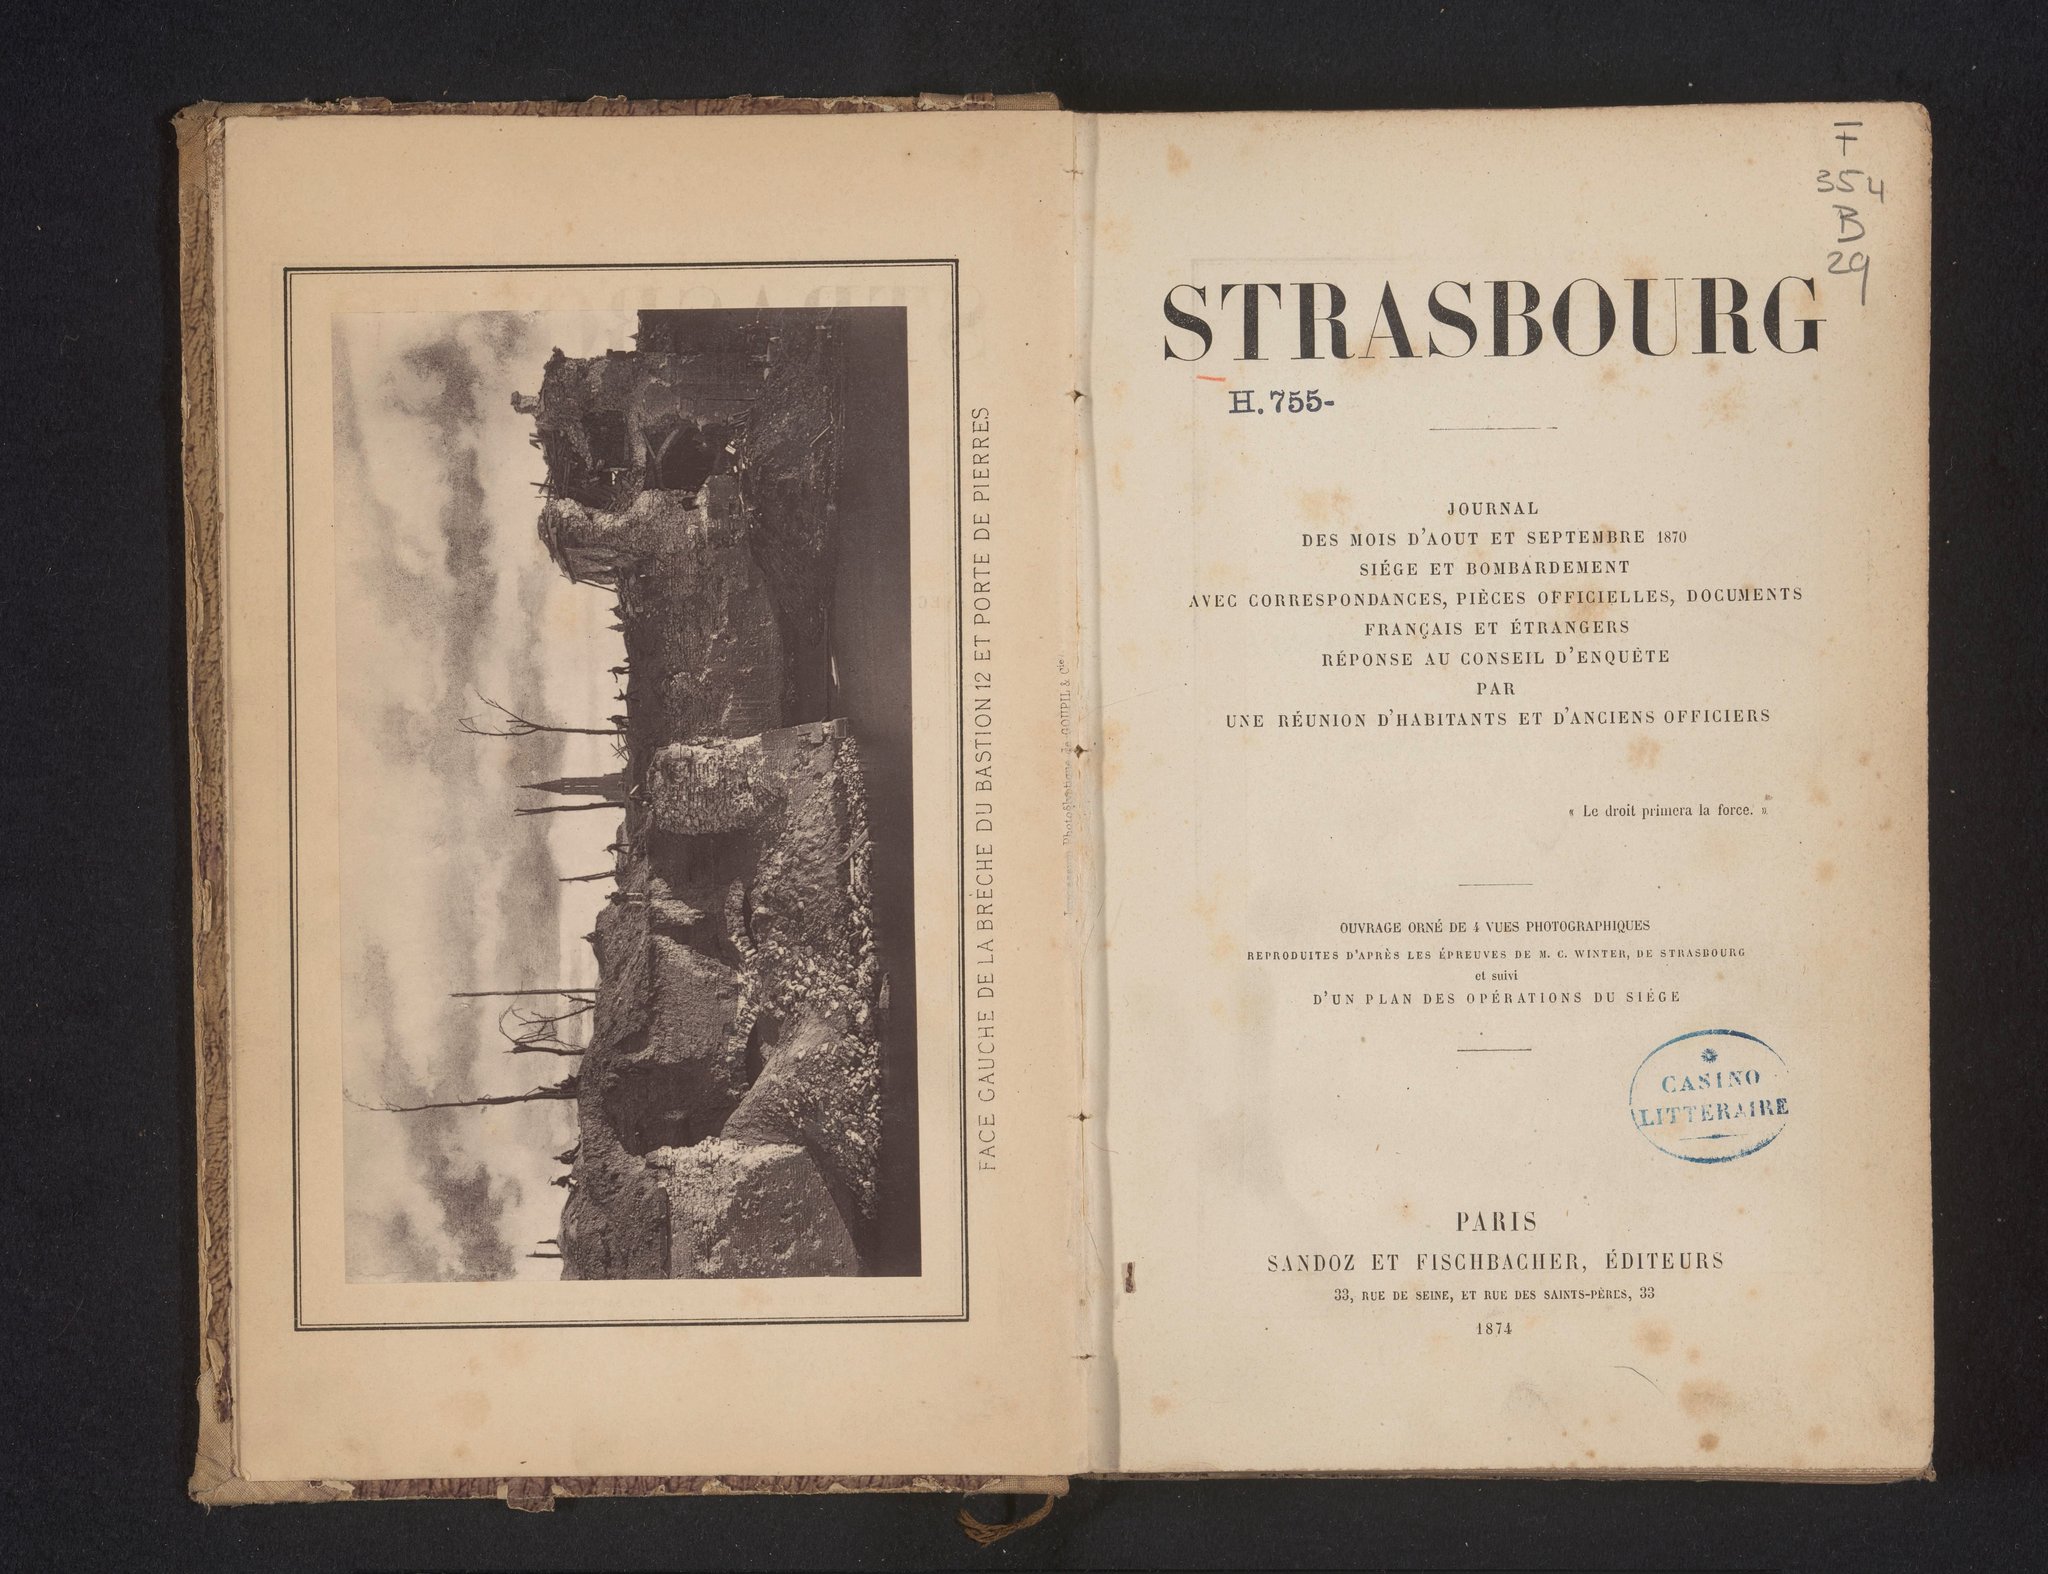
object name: page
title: Gezicht op een bres in een bastion te Straatsburg ten gevolge van de belegering door het Duitse leger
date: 1870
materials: paper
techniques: woodburytype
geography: straatsburg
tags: landscape with ruins, assault ~ siege, consequences of war